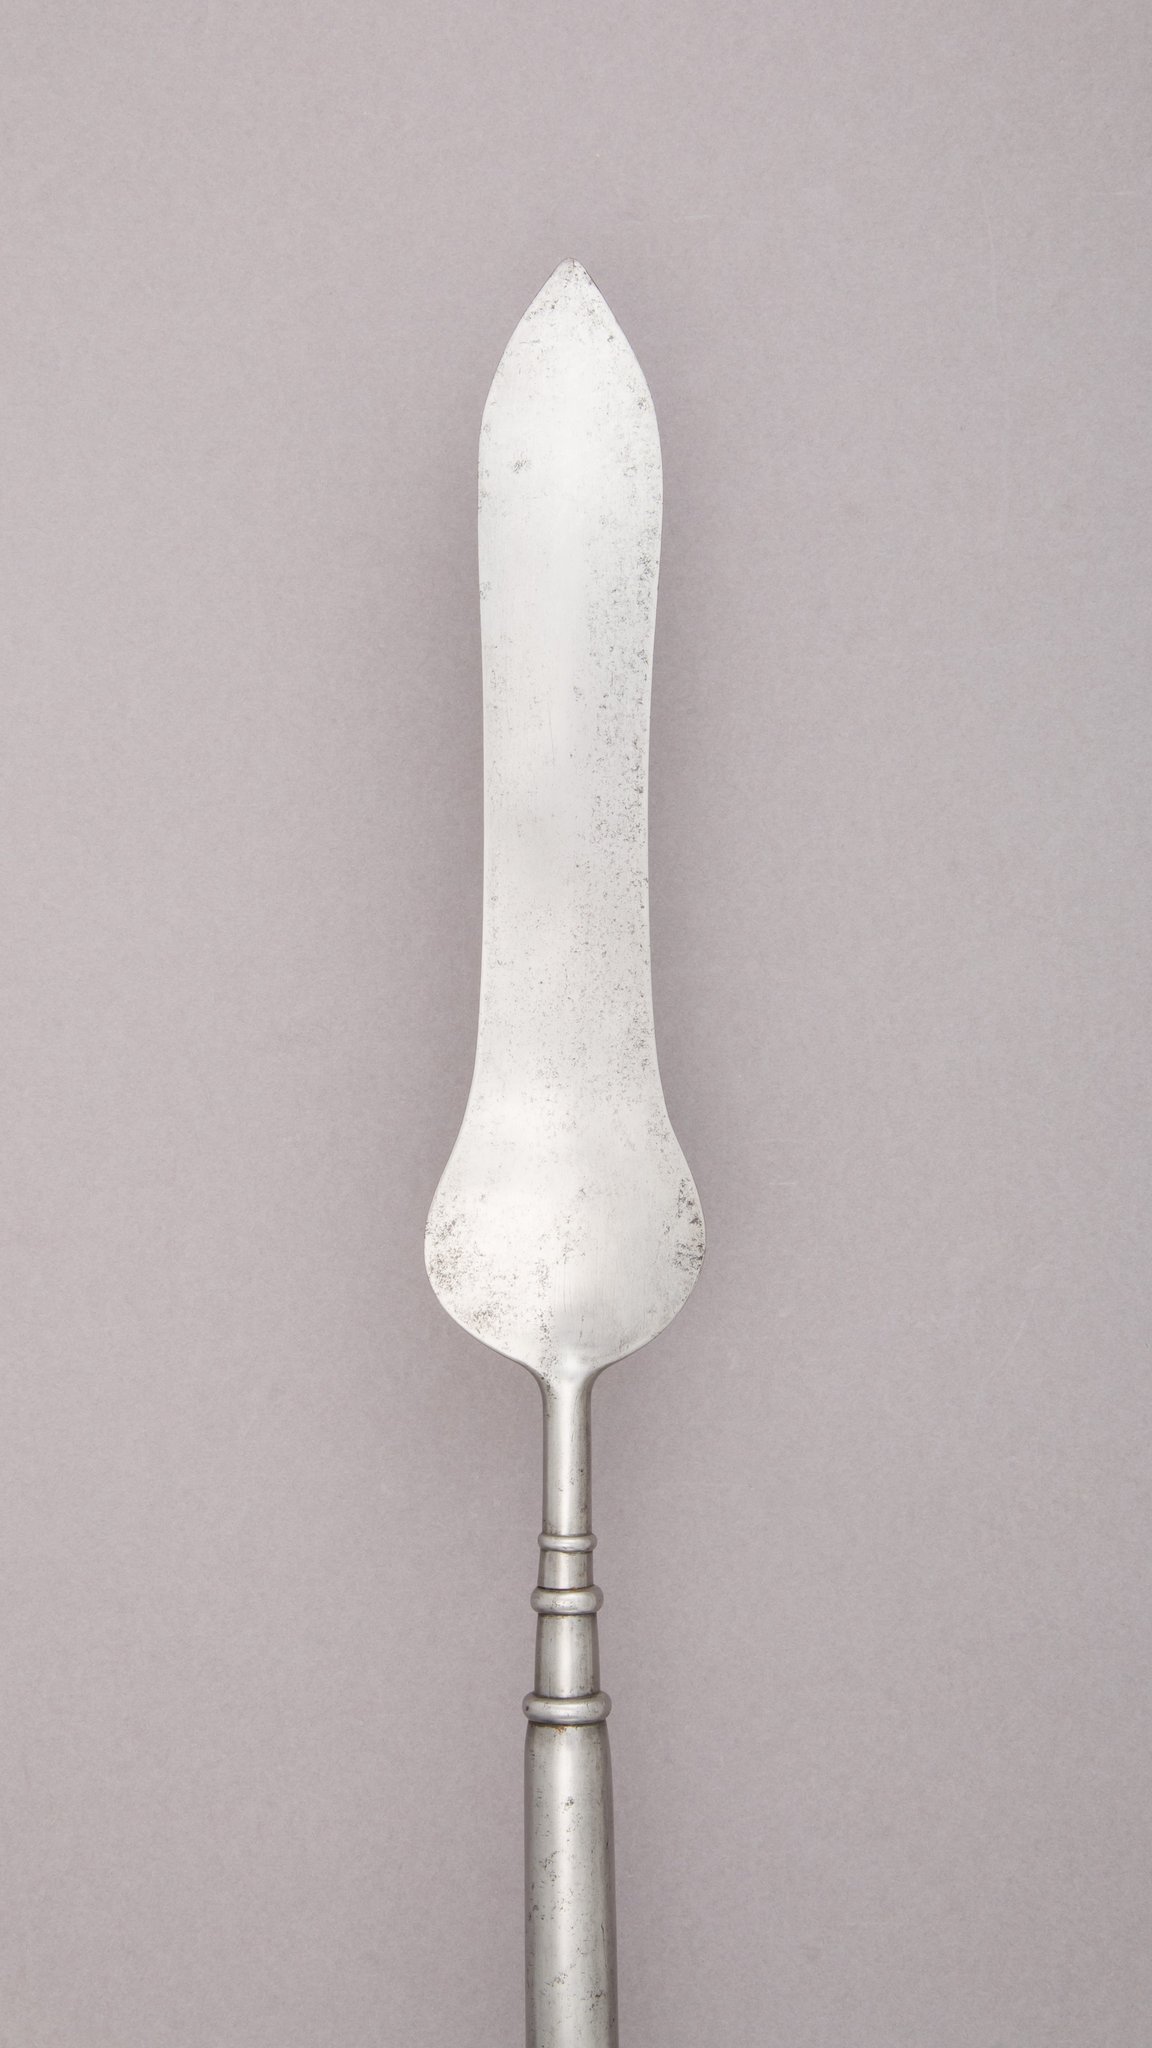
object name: spontoon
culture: american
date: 1770-1790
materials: steel, wood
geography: united states